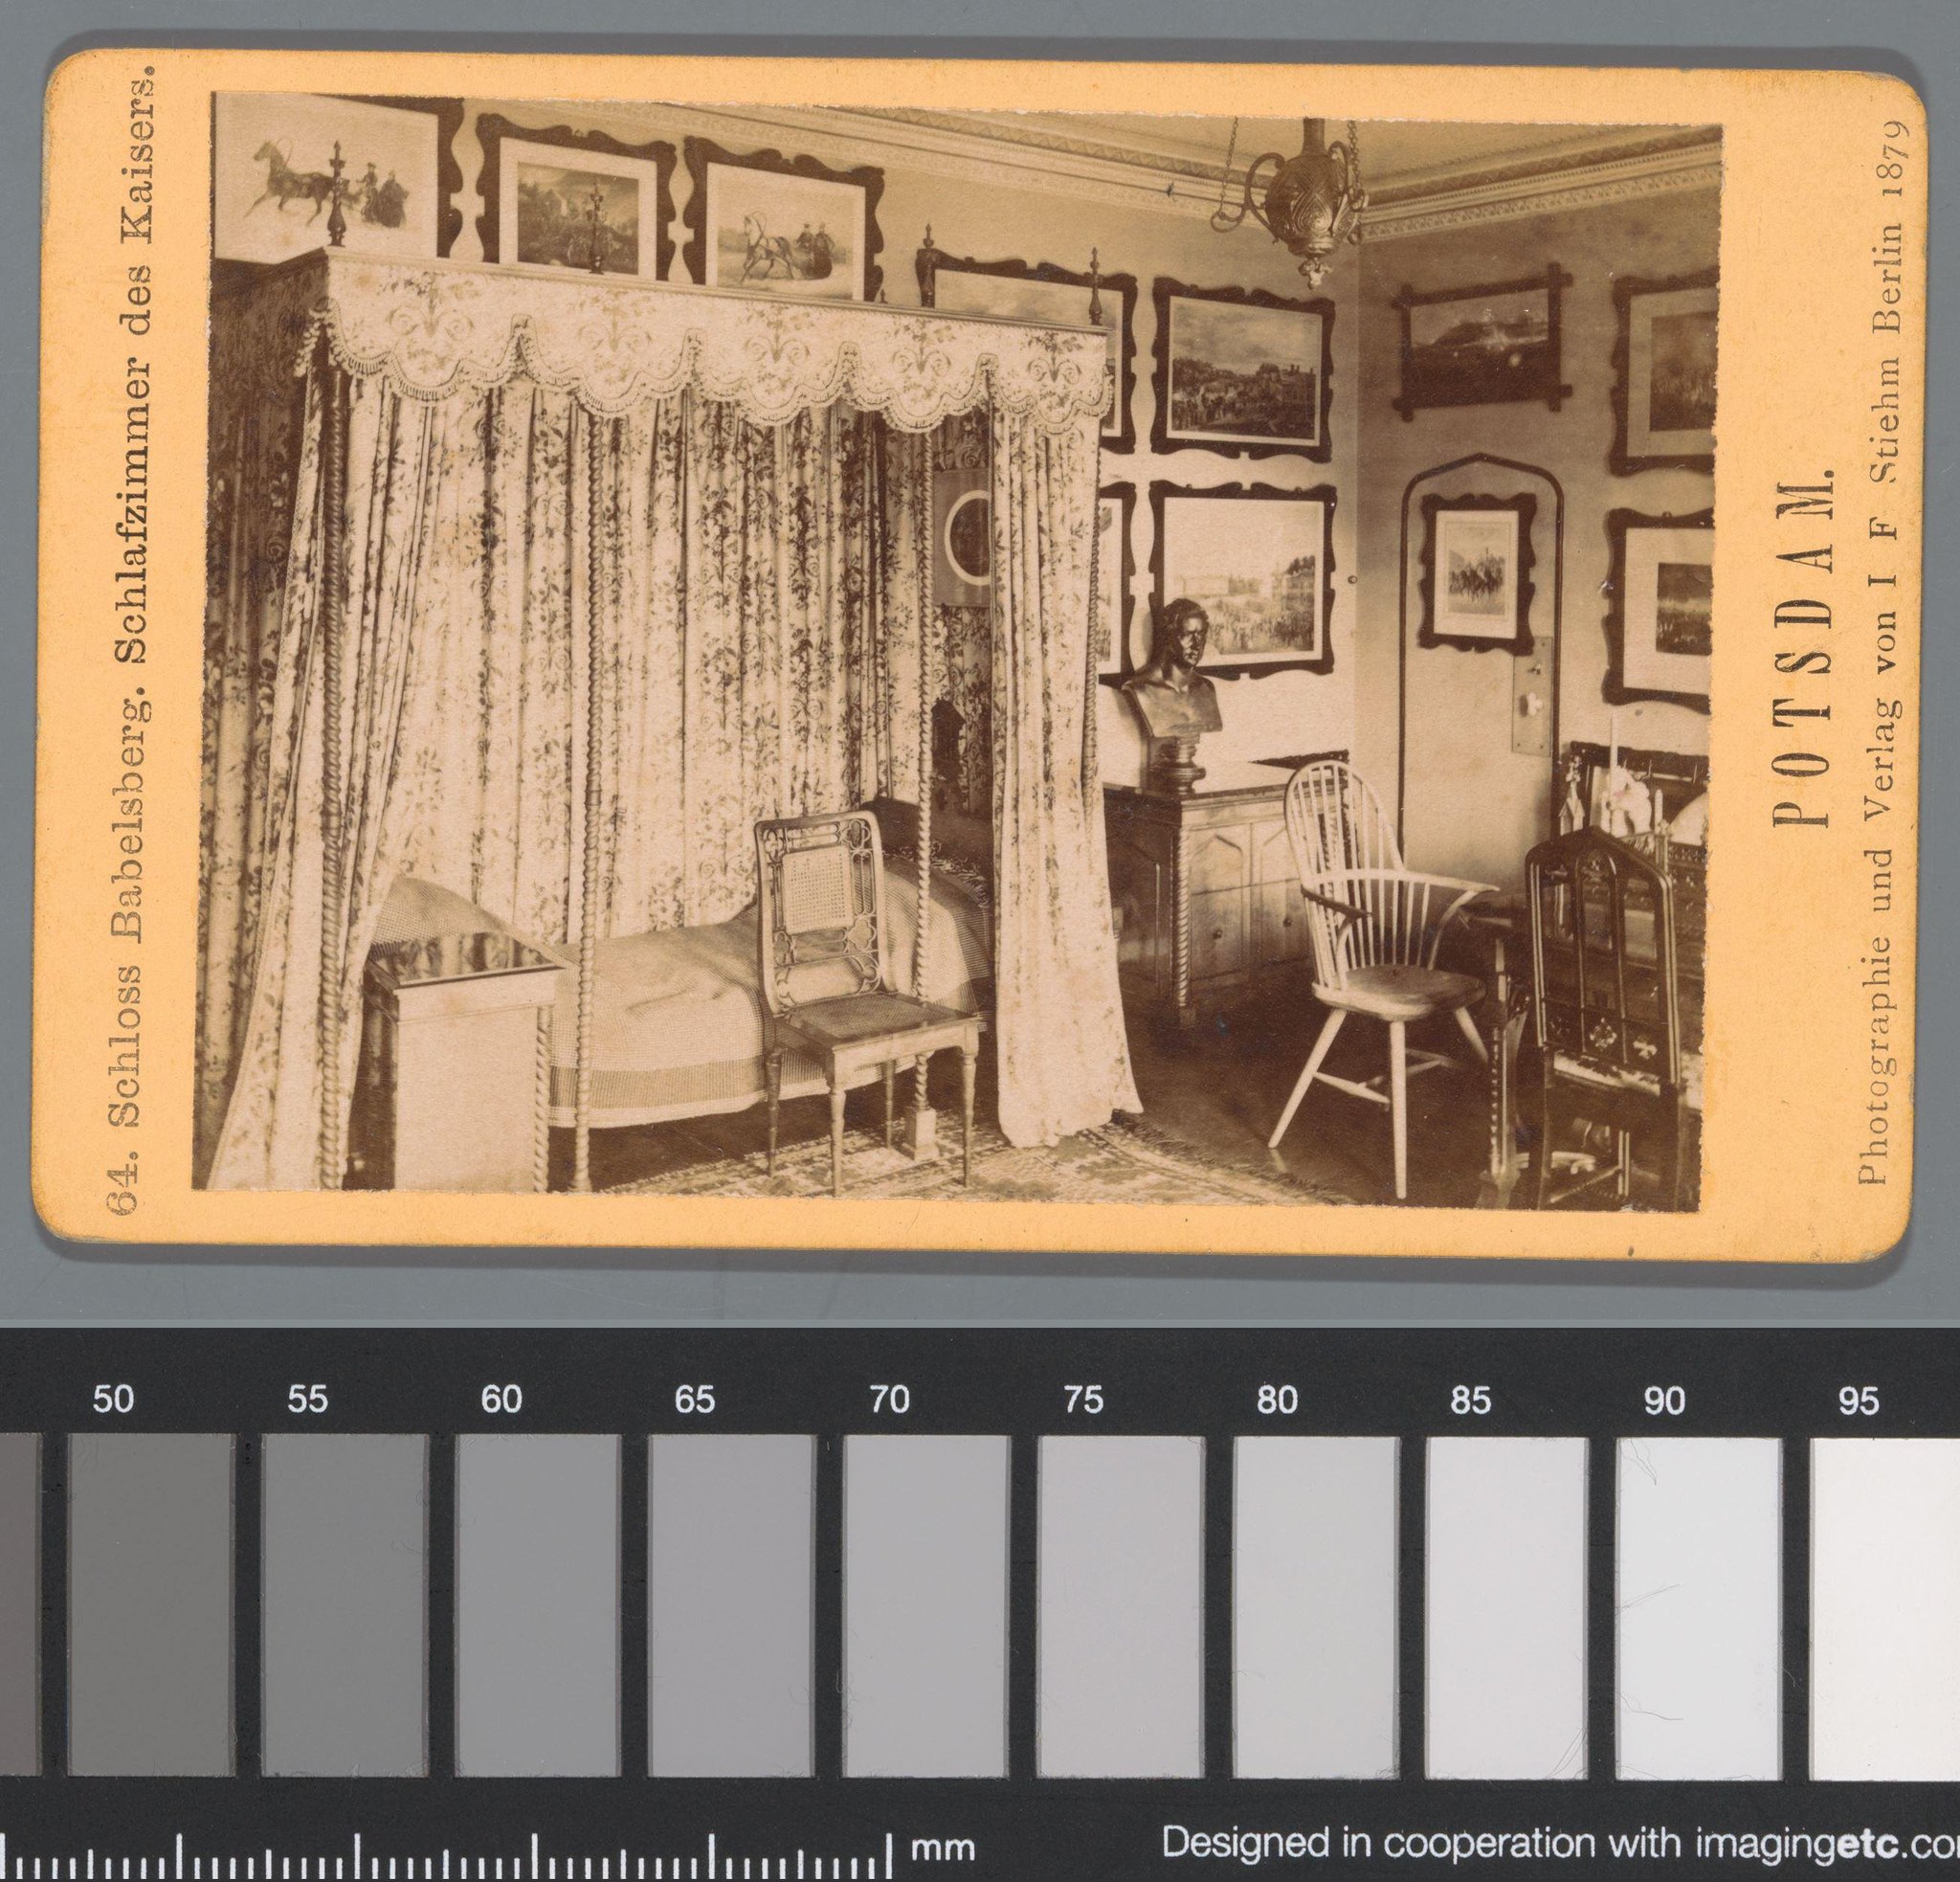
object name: carte de visite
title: Slaapkamer van de Duitse keizer in slot Babelsberg, Potsdam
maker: johann friedrich stiehm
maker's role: fotograaf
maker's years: 1826-1902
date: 1879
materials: cardboard, paper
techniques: albumen print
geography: berlin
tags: bedroom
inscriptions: number: ‘64.’